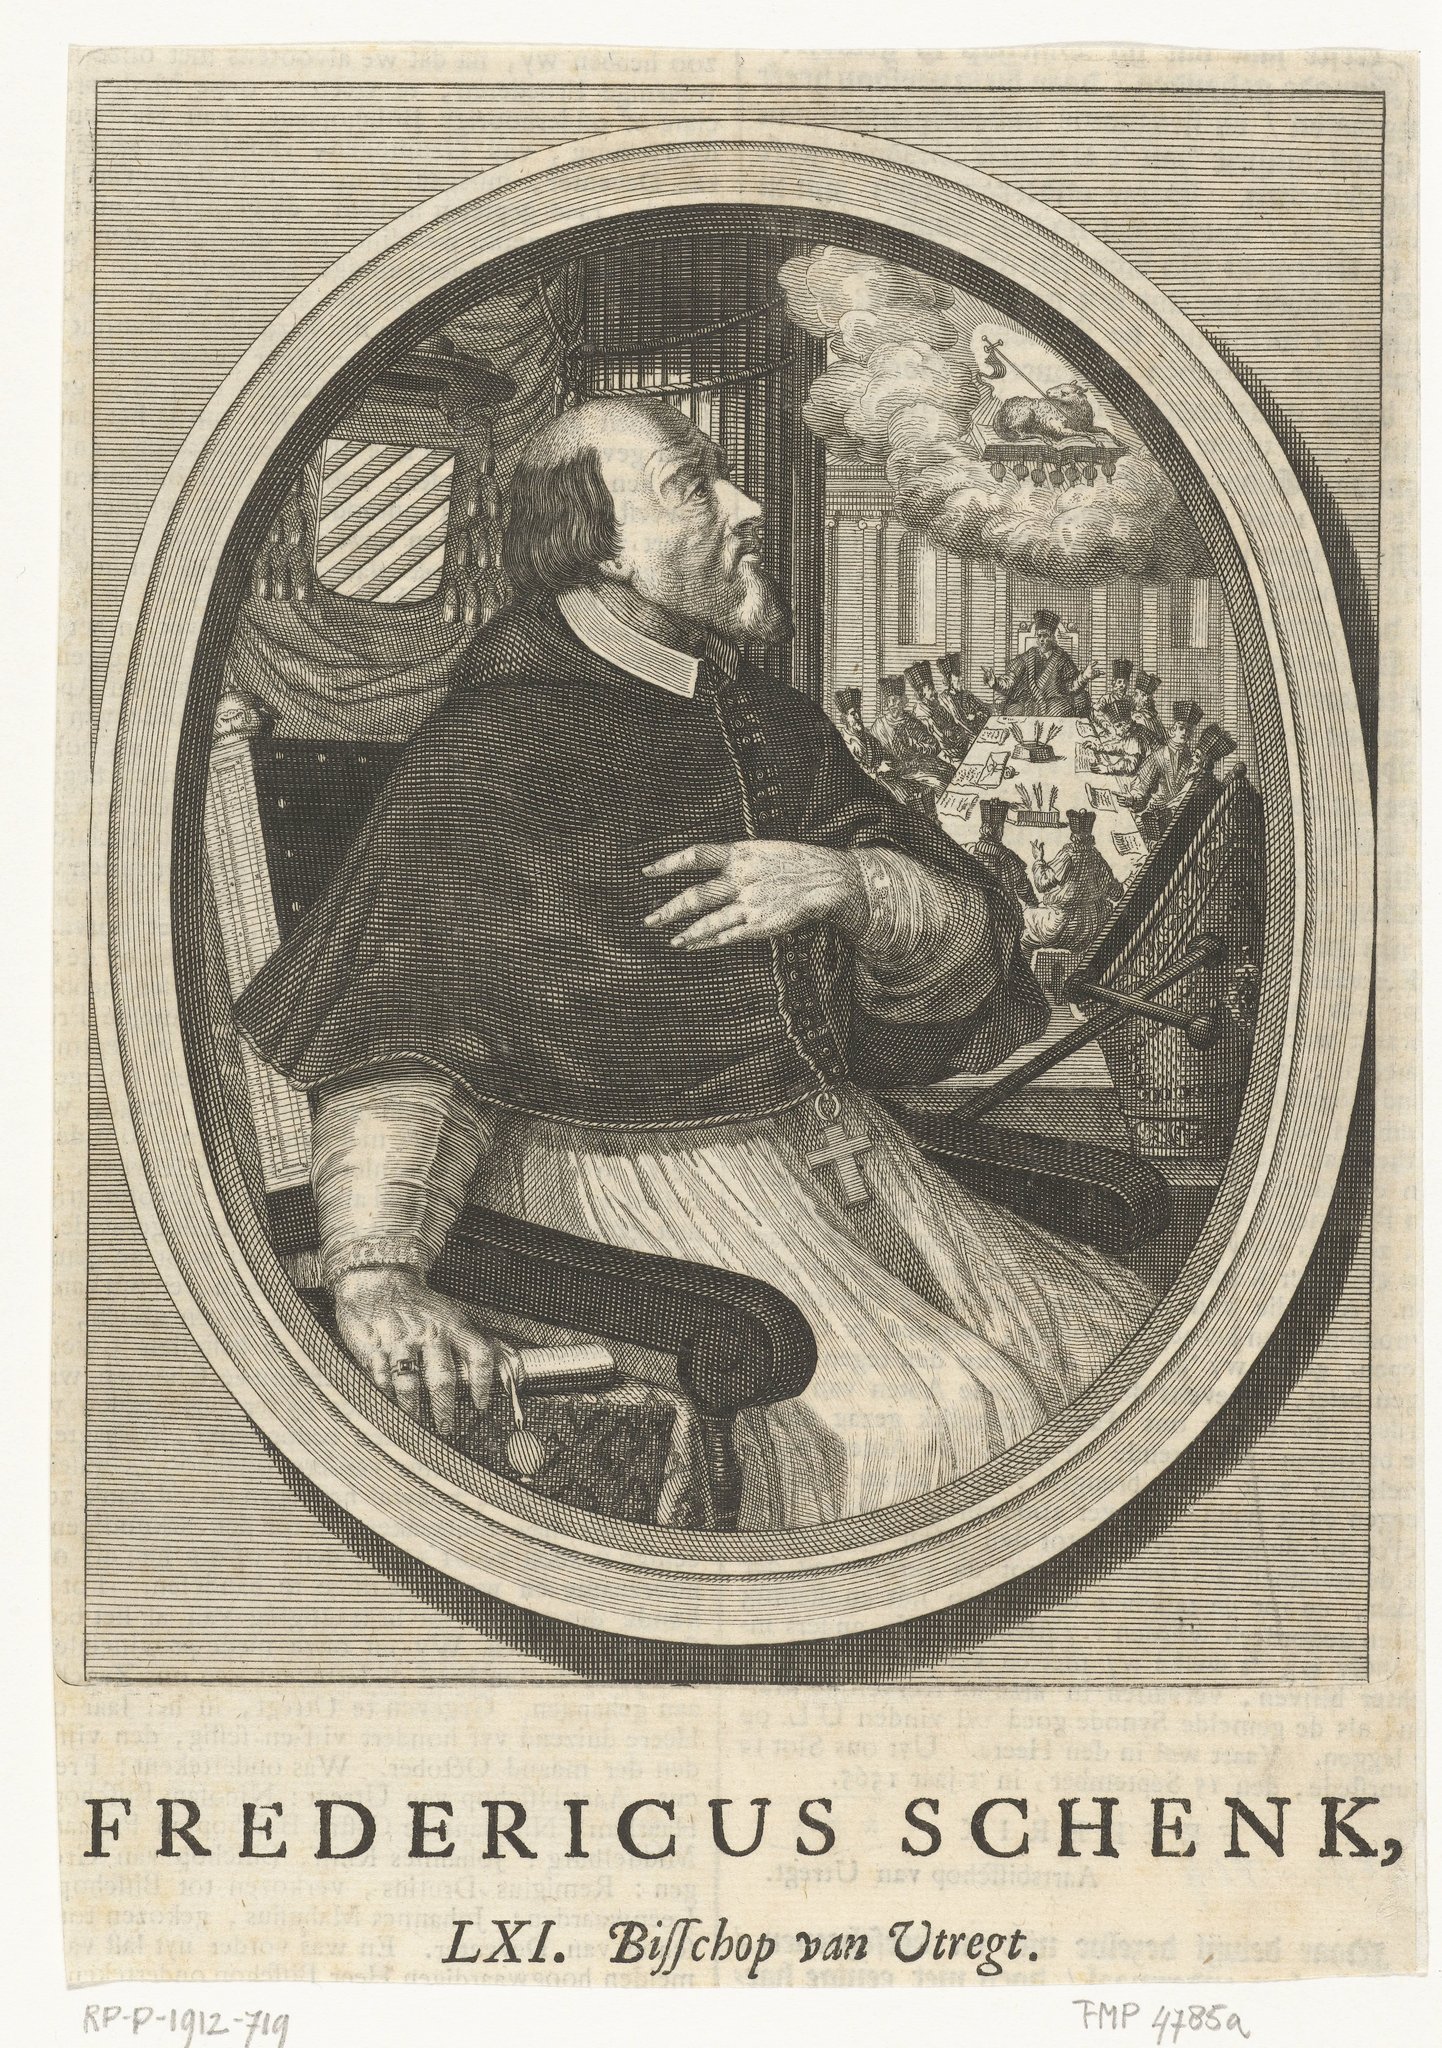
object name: print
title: Fredericus Schenk LXI. Bisschop van Utregt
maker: françois van bleyswijck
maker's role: draughtsman, print maker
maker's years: 1671-1746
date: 1681-1726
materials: paper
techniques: engraving, etching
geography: leiden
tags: archbishop, bishop, etc. (roman catholic), lamb bearing cross or banner, 'agnus dei' ~ symbol of christ, the vision of the lamb and the book with the seven seals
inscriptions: collector's mark: Lugt 2228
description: Portret van Frederik Schenk van Toutenburg, aartsbisschop van Utrecht zittend op stoel terwijl zijn blik is gericht op verschijning van Lam Gods het boek met zeven zegels en kruisvaandel. Naast de aartsbisschop liggen zijn kruisstaf en mijter en voor een gordijn is zijn wapen weergegeven. Een scène op de achtergrond toont een kerkvergadering. Kniestuk in ovale omlijsting. Op verso staan twee kolommen Nederlandse tekst in gotisch schrift.